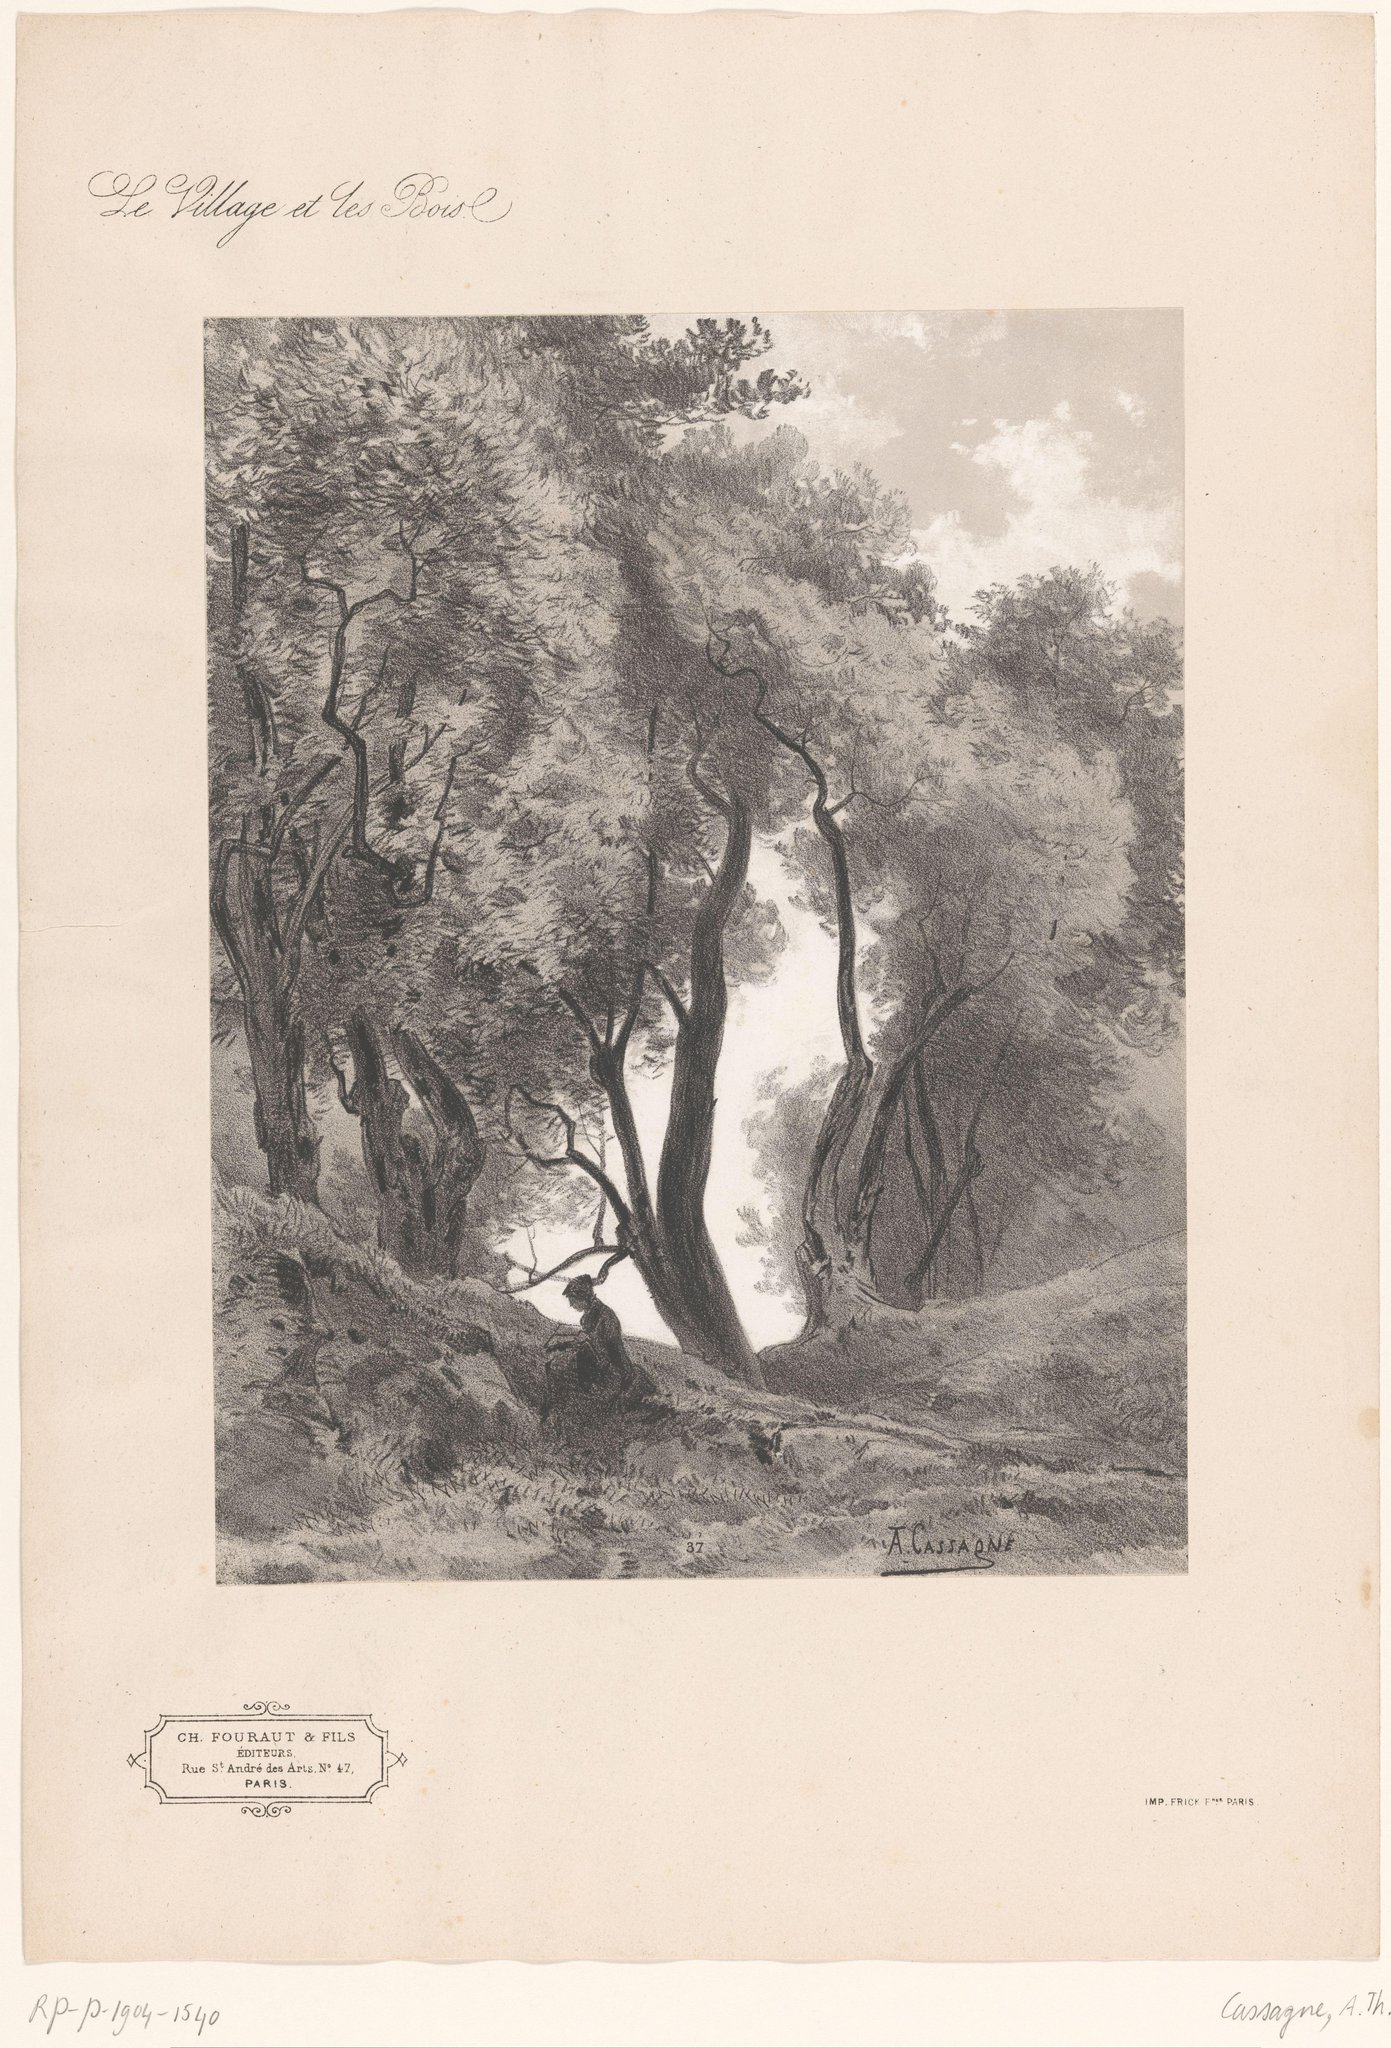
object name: print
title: Le village et les bois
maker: armand théophile cassagne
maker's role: print maker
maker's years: 1823-1907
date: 1872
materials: paper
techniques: tone lithography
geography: paris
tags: reading, forest, wood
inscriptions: collector's mark: Lugt 2228a, stamp: ‘Ch. Fouraut & Fils, éditeurs, Rue St. André des Arts, no. 47, Paris.’